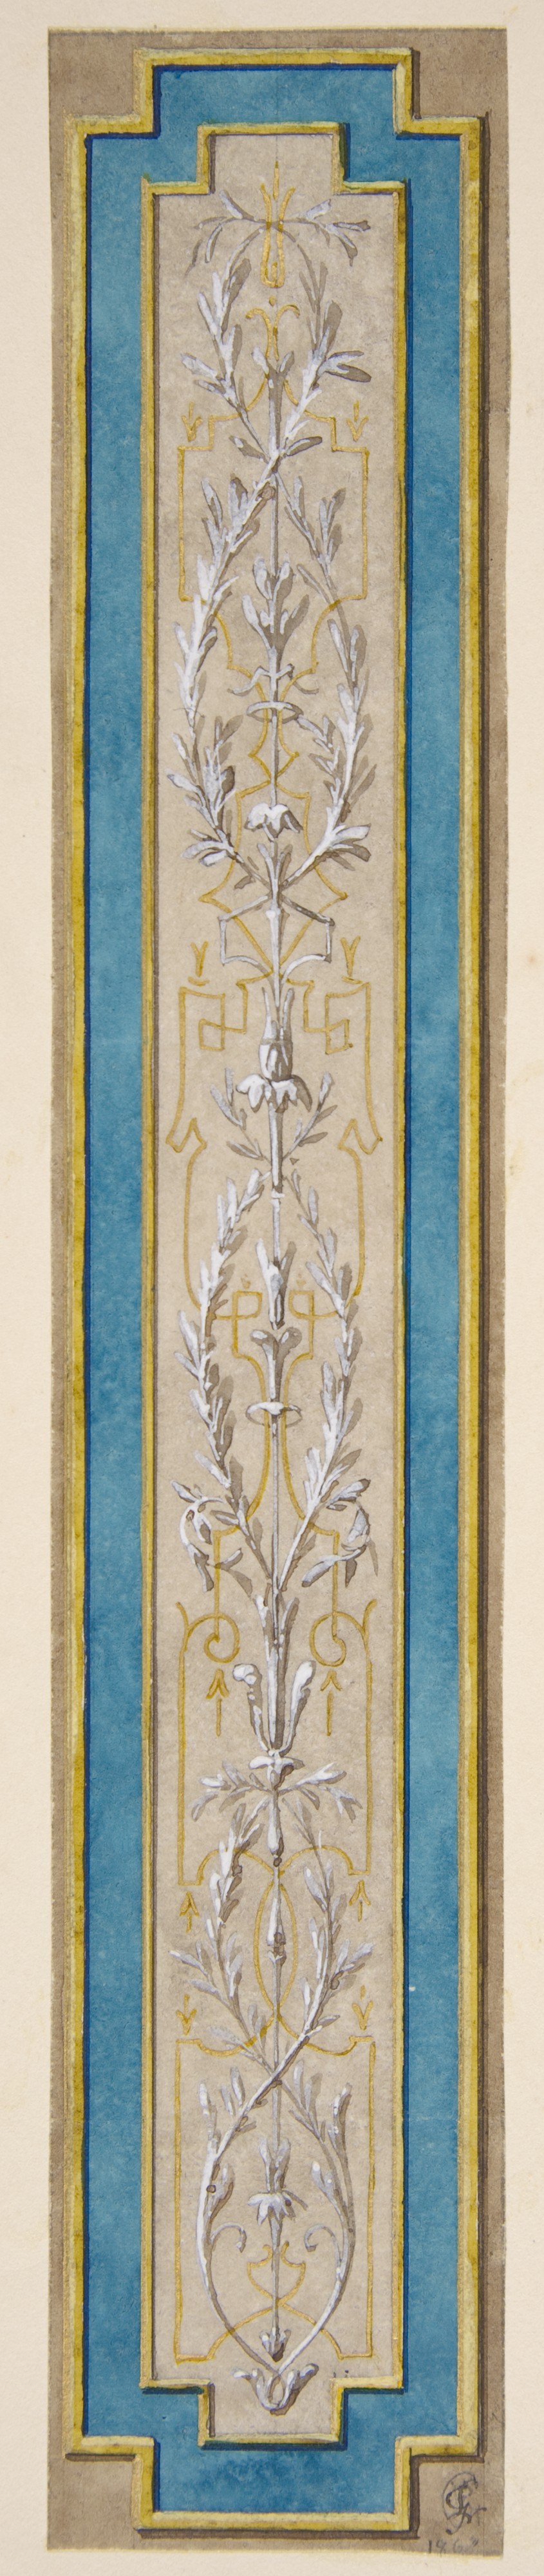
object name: drawing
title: Design for a decorative panel painted in rococco style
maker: jules-edmond-charles lachaise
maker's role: artist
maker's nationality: french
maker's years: 1897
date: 1830-1897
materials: gold paint, graphite, ink, watercolor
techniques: heightening, pen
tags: ornament